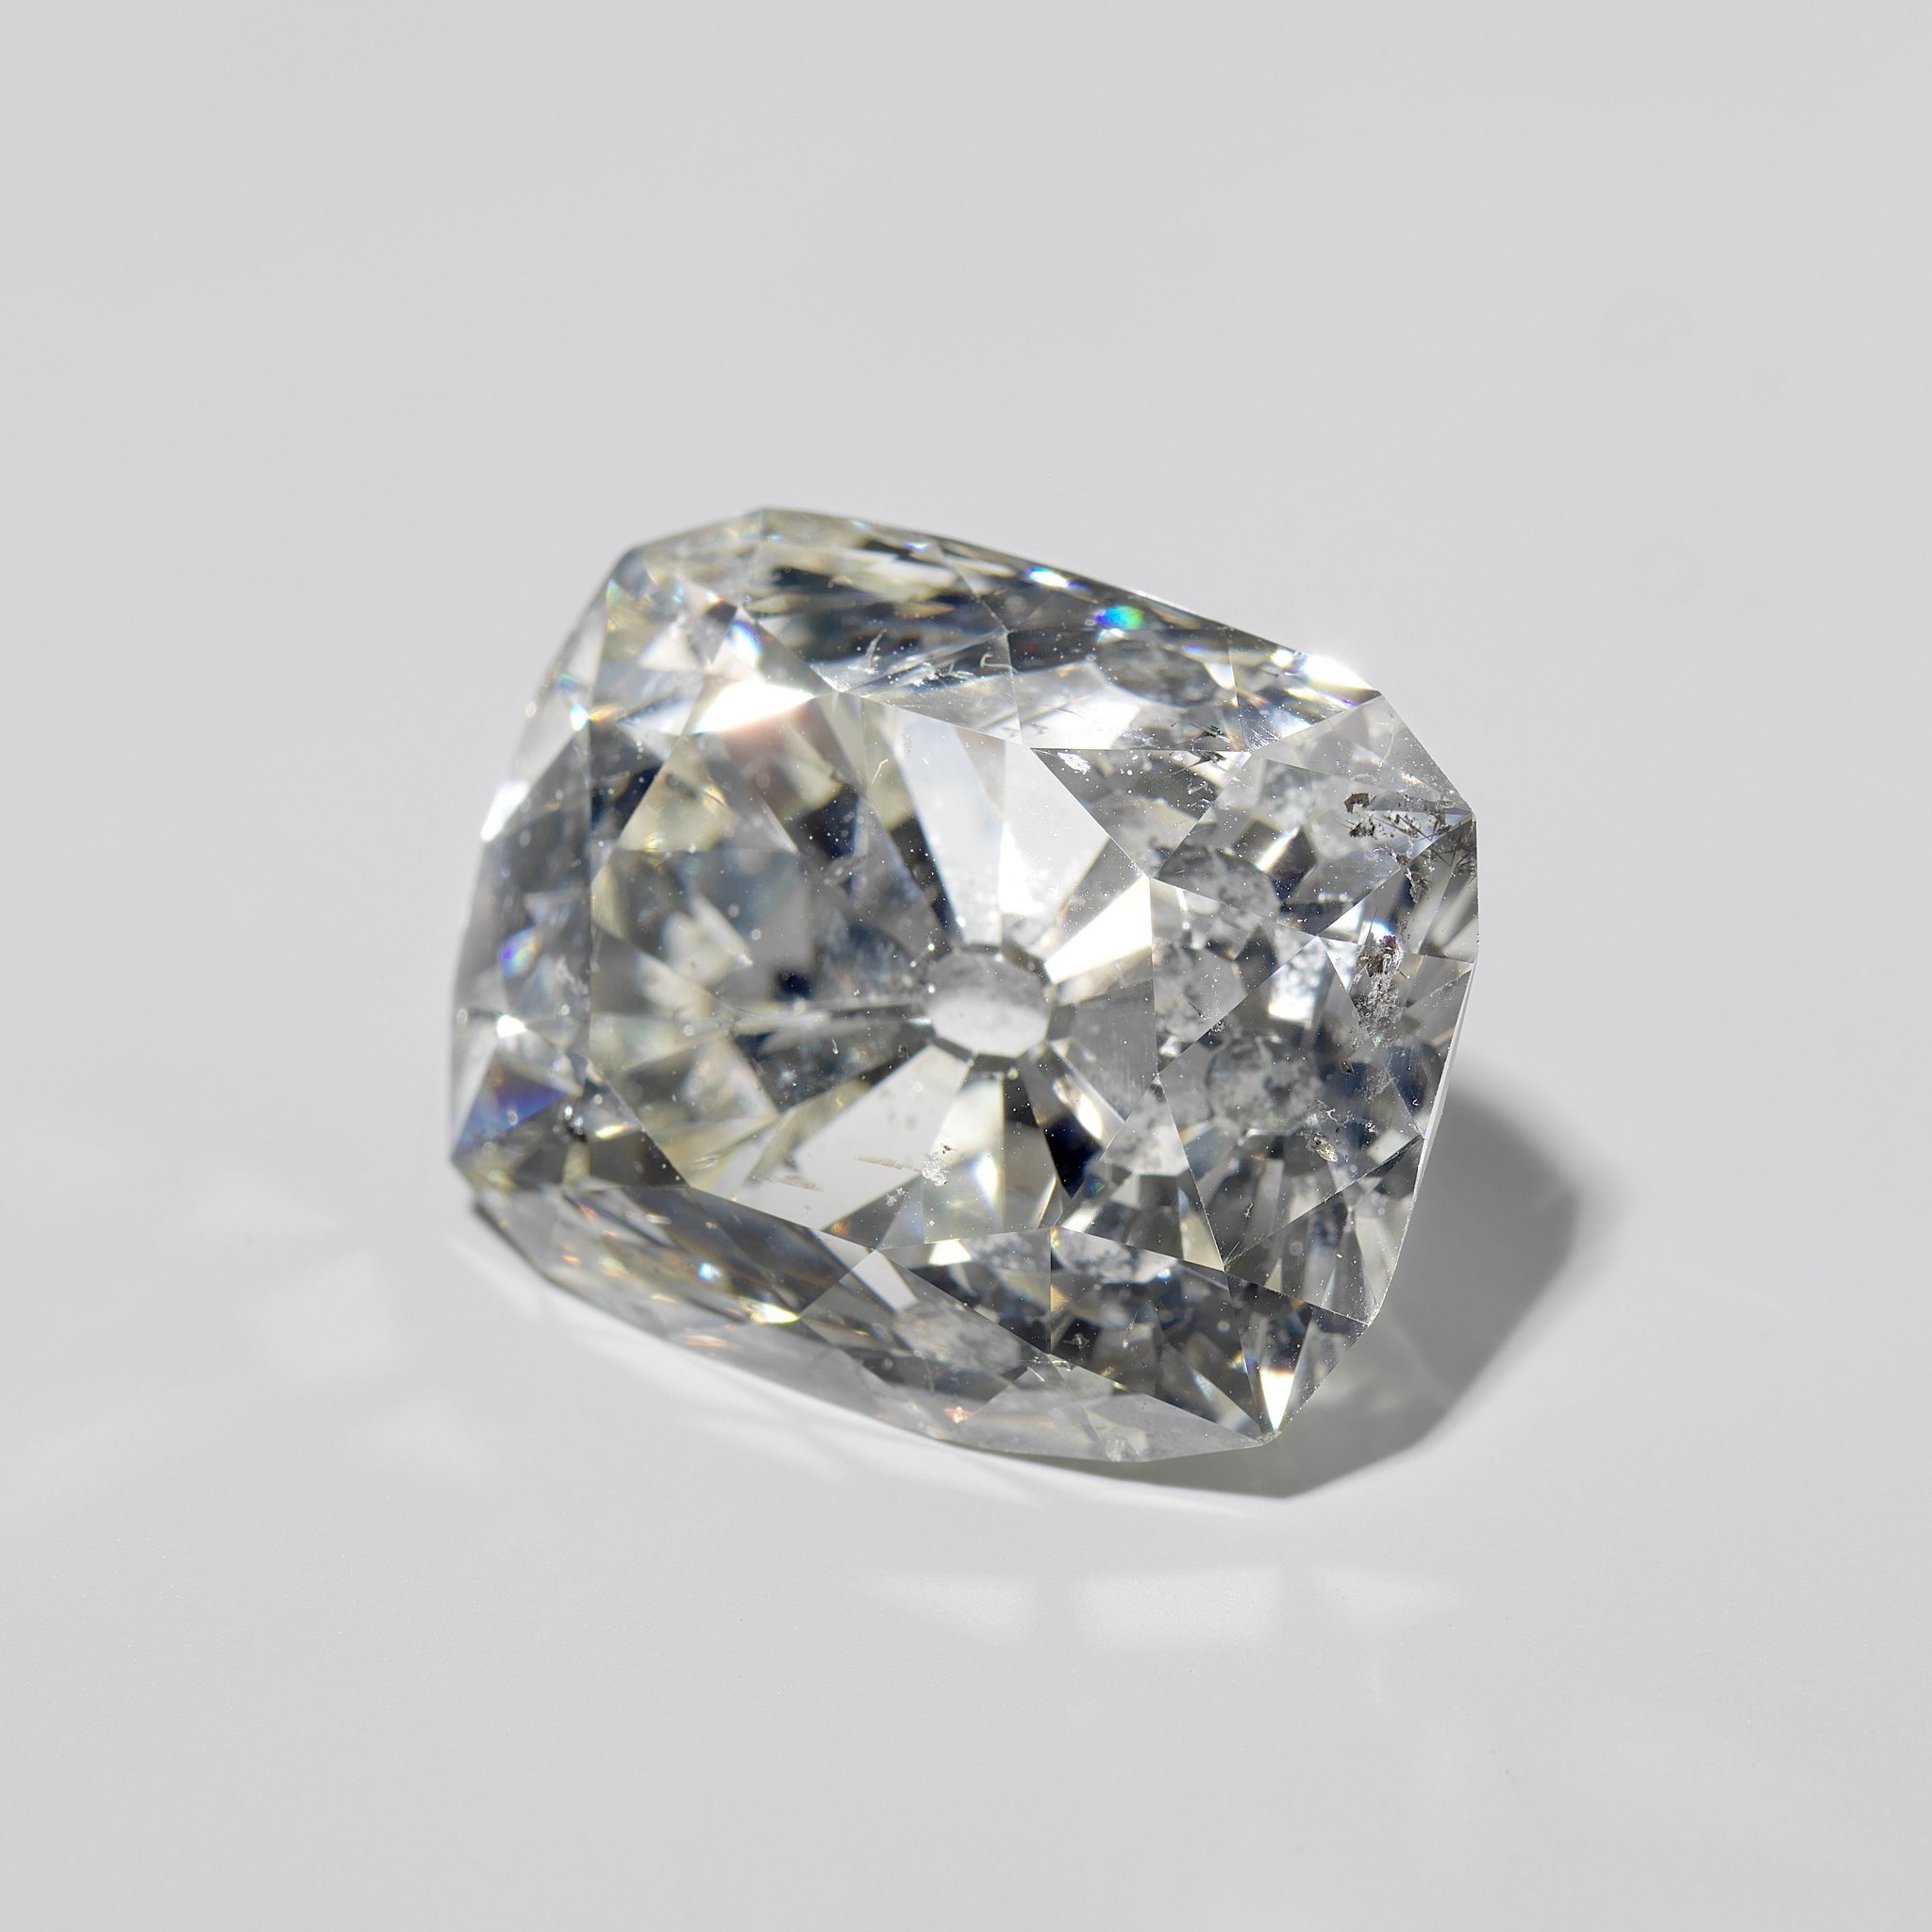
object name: diamond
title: The Banjarmasin Diamond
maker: Anonymous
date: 1835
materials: diamond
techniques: grinding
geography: borneo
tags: borneo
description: This diamond is war booty. It was once owned by Panembahan Adam, the sultan of Banjarmasin (Kalimantan). The stone belonged to the state heirlooms, symbols of the sultan’s sovereignty. After his death, the Netherlands intervened in the battle of succession. In 1859 Dutch troops violently seized control of Banjarmasin and abolished the sultanate. The rough diamond was sent to the Netherlands, where it was cut into a rectangle of 36 carats.